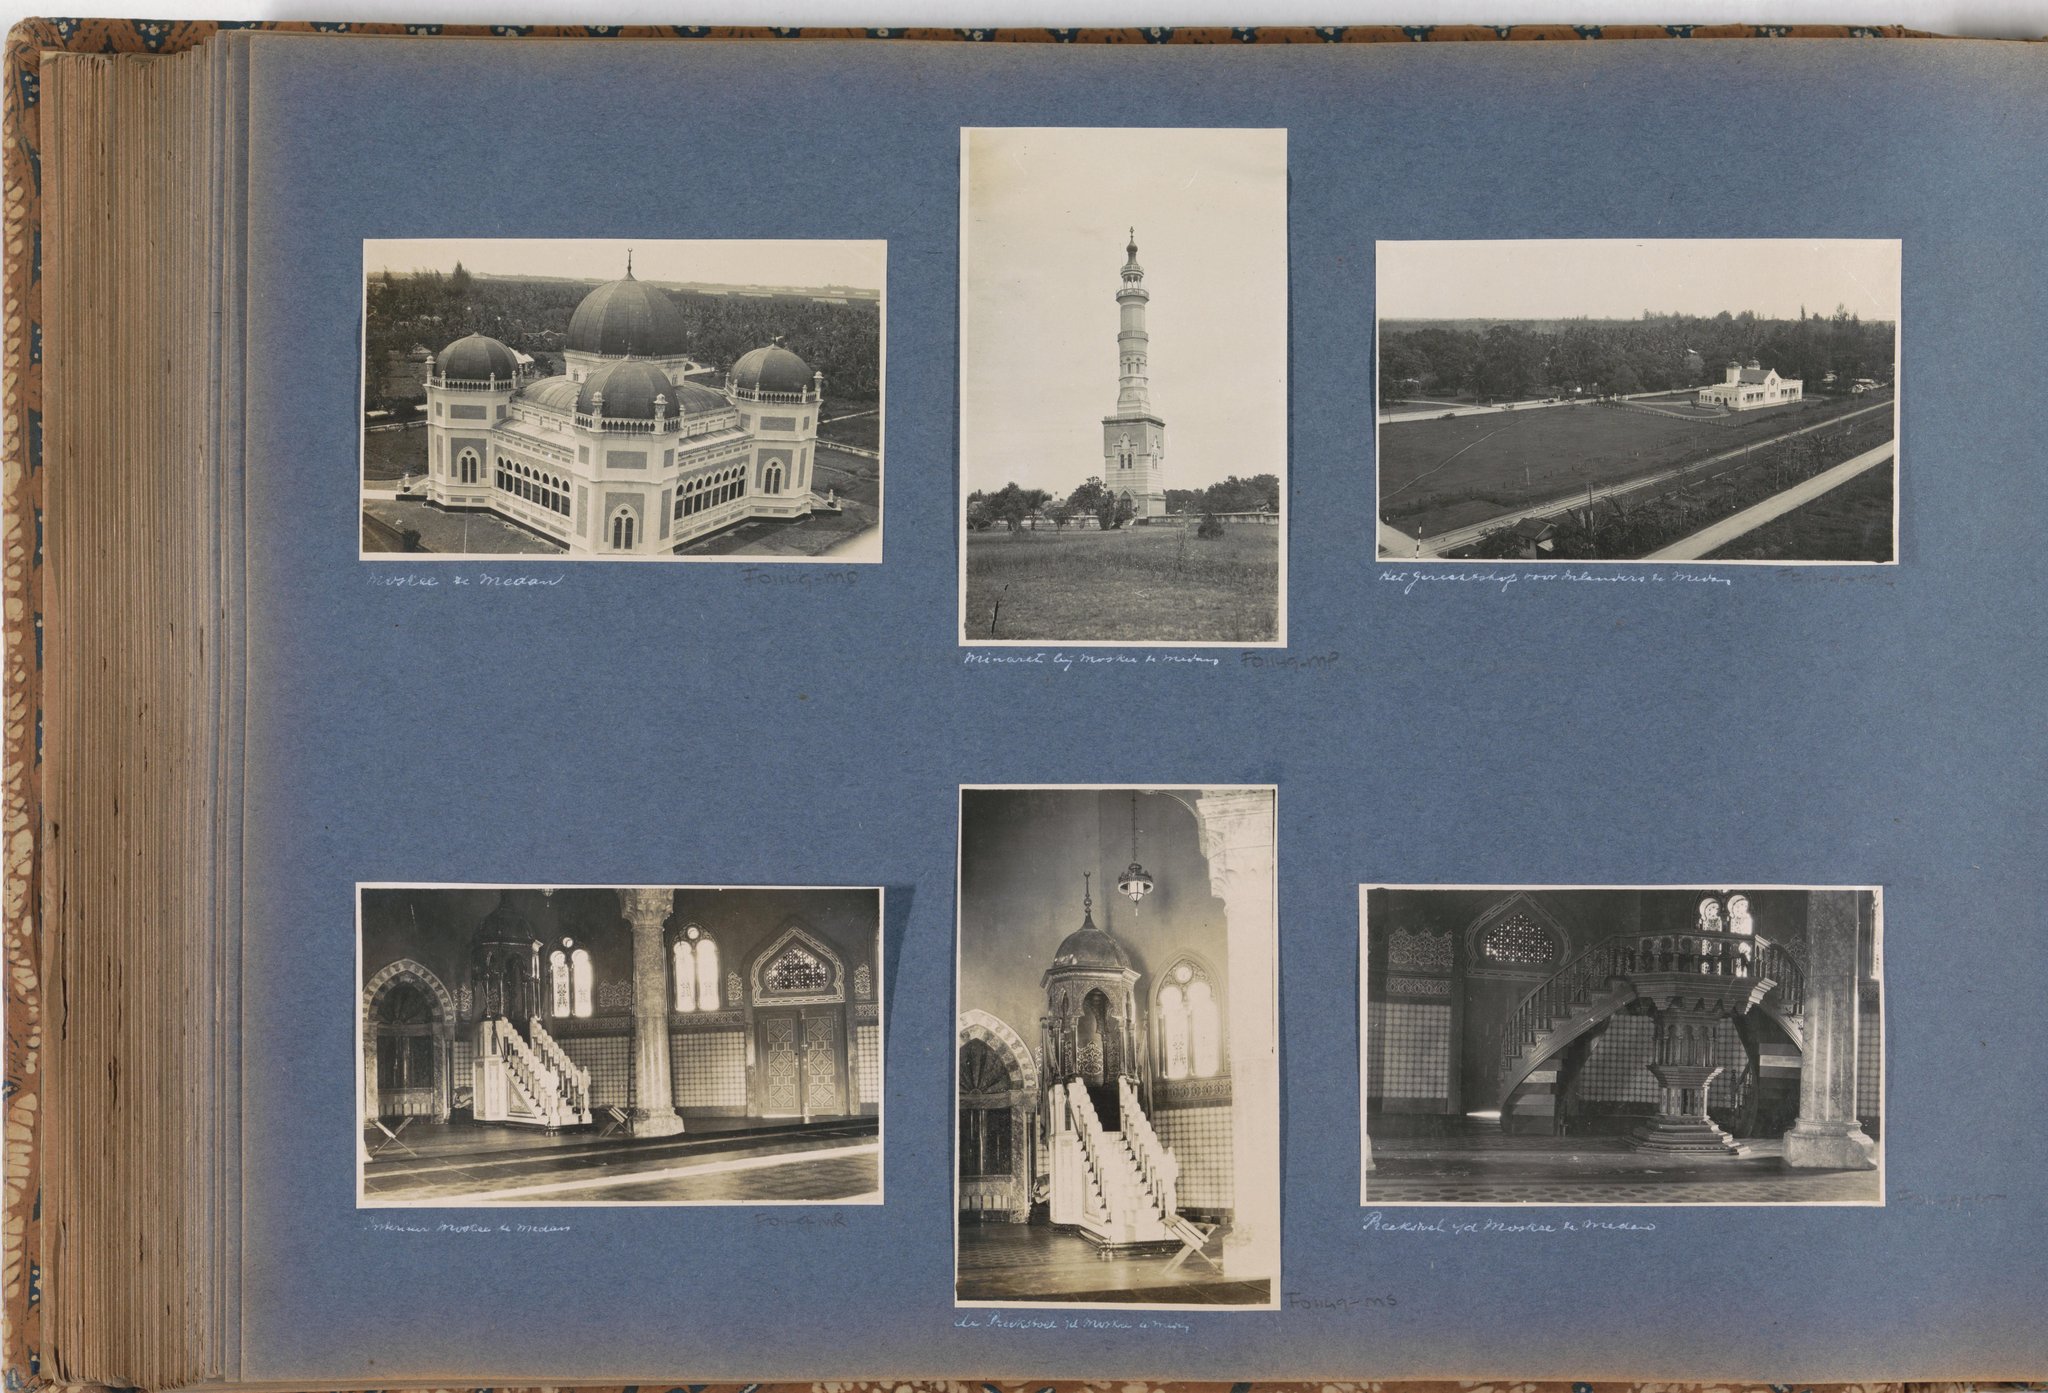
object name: photograph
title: Exterieur van een gerechtshof en omliggend terrein in Medan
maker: Anonymous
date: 1900-1920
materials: paper, photographic support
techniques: gelatin silver print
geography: medan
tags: court building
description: Onderdeel van reisalbum met foto's van bedrijvigheid en bezienswaardigheden op Sumatra en Java en van de reis naar en van Nederlands-Indië.